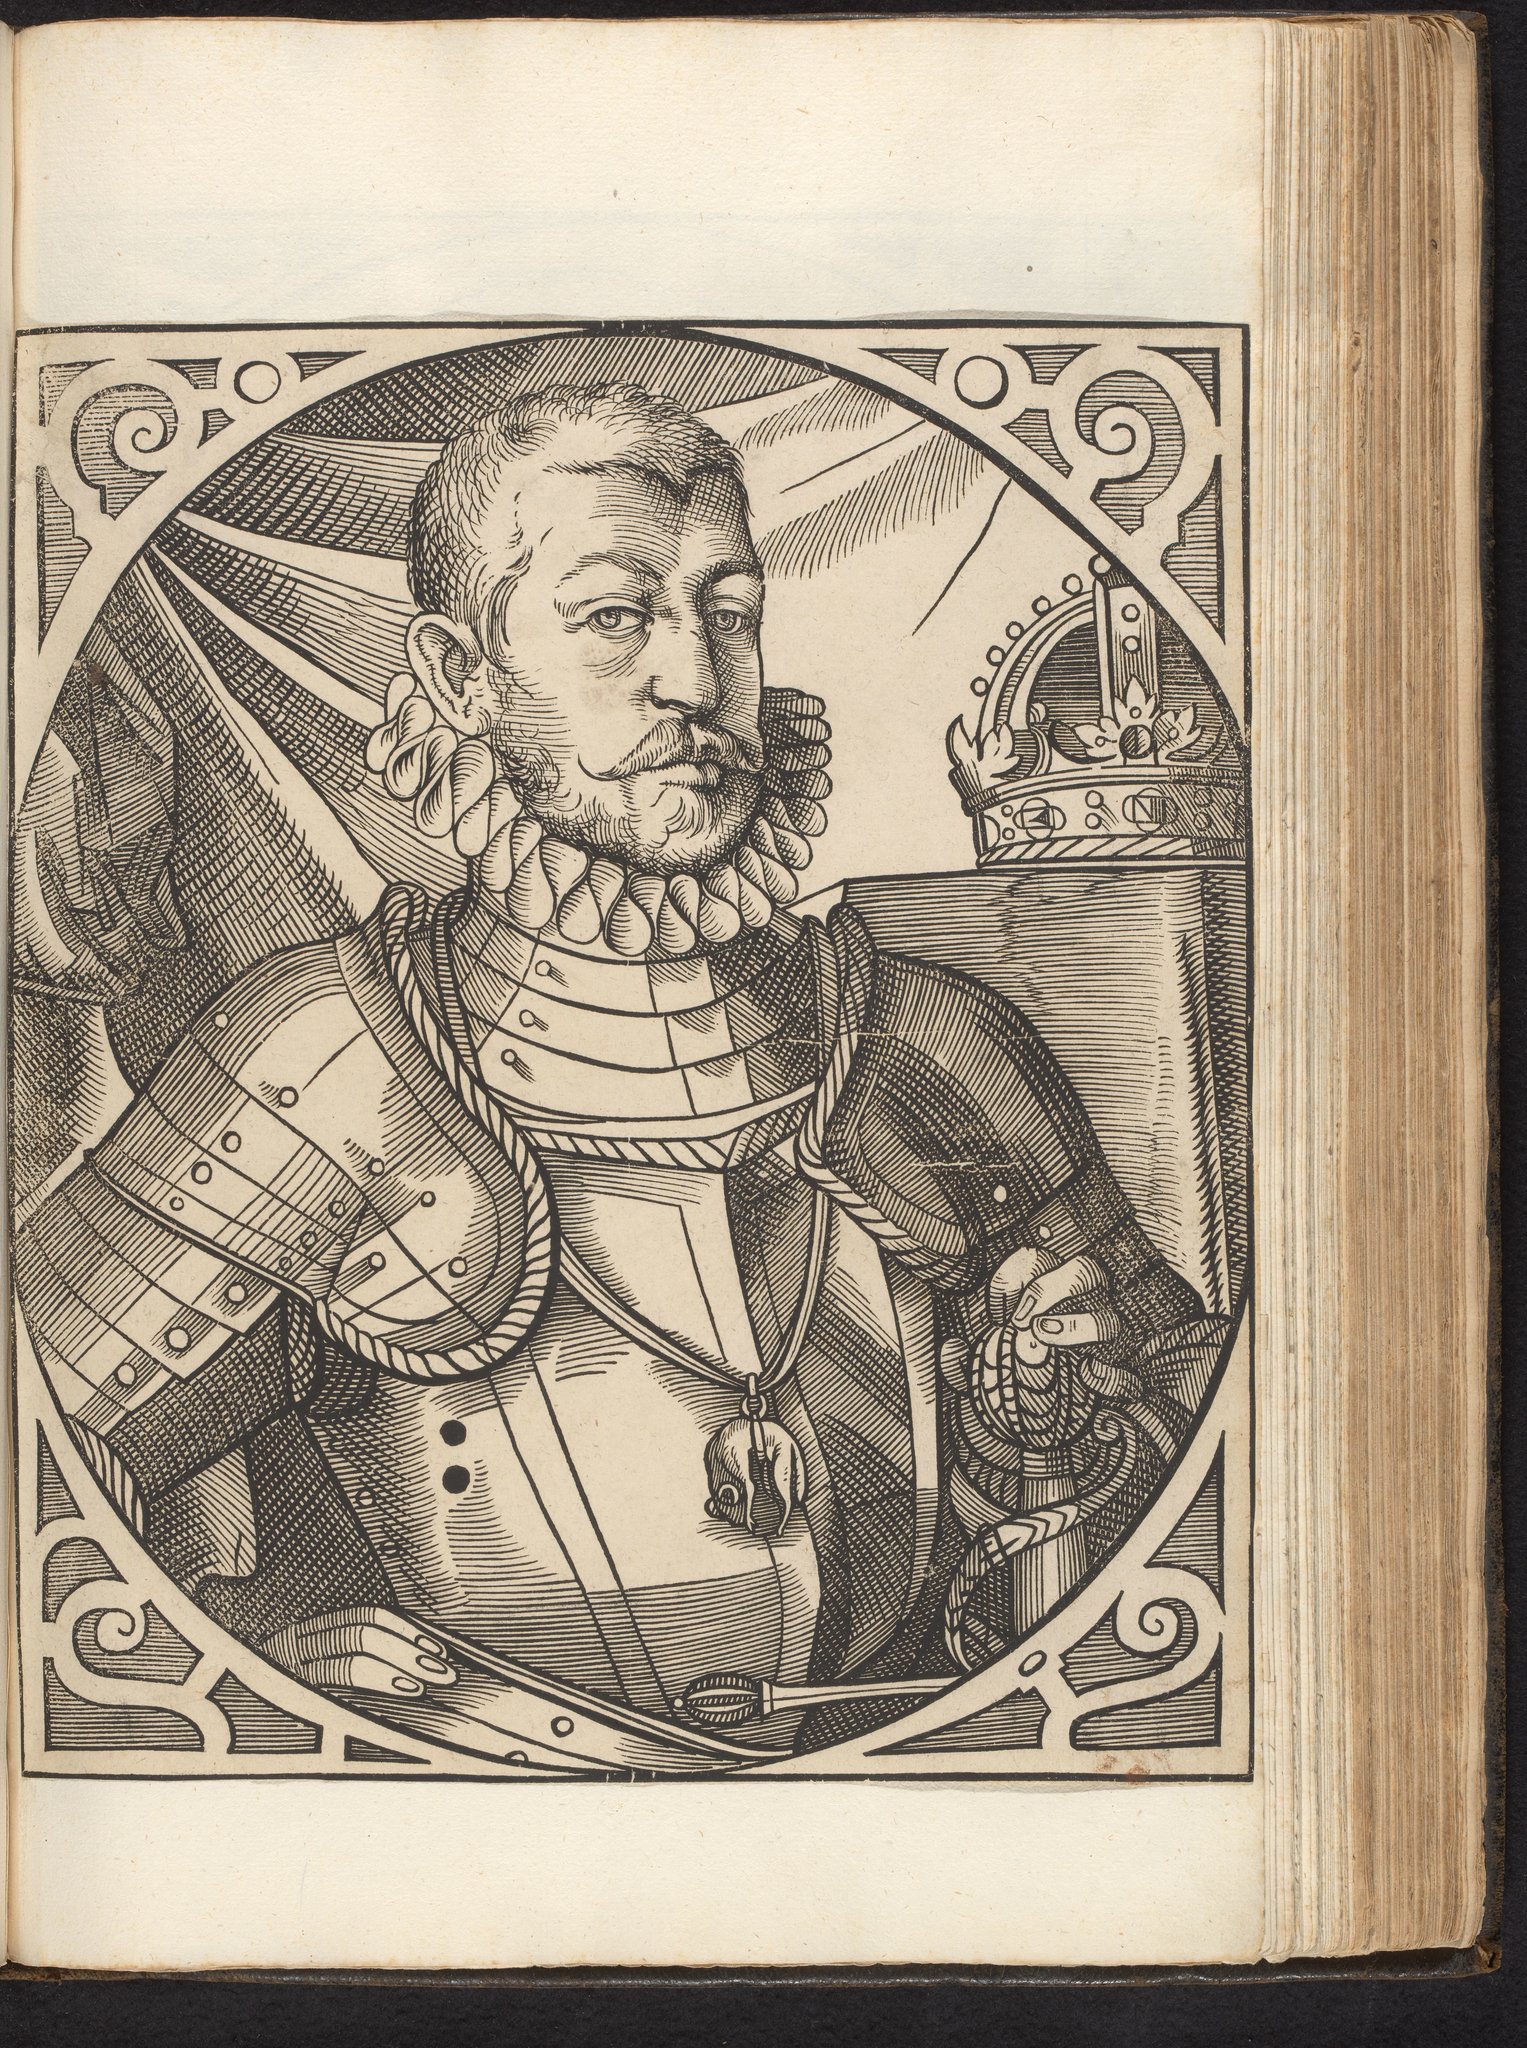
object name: album leaf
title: Portret van een onbekende man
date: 1549-1584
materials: paper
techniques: woodcut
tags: historical persons, ruler, sovereign, knighthood order of the golden fleece - insignia of a knighthood order, e.g.: badge, chain (with name of order)